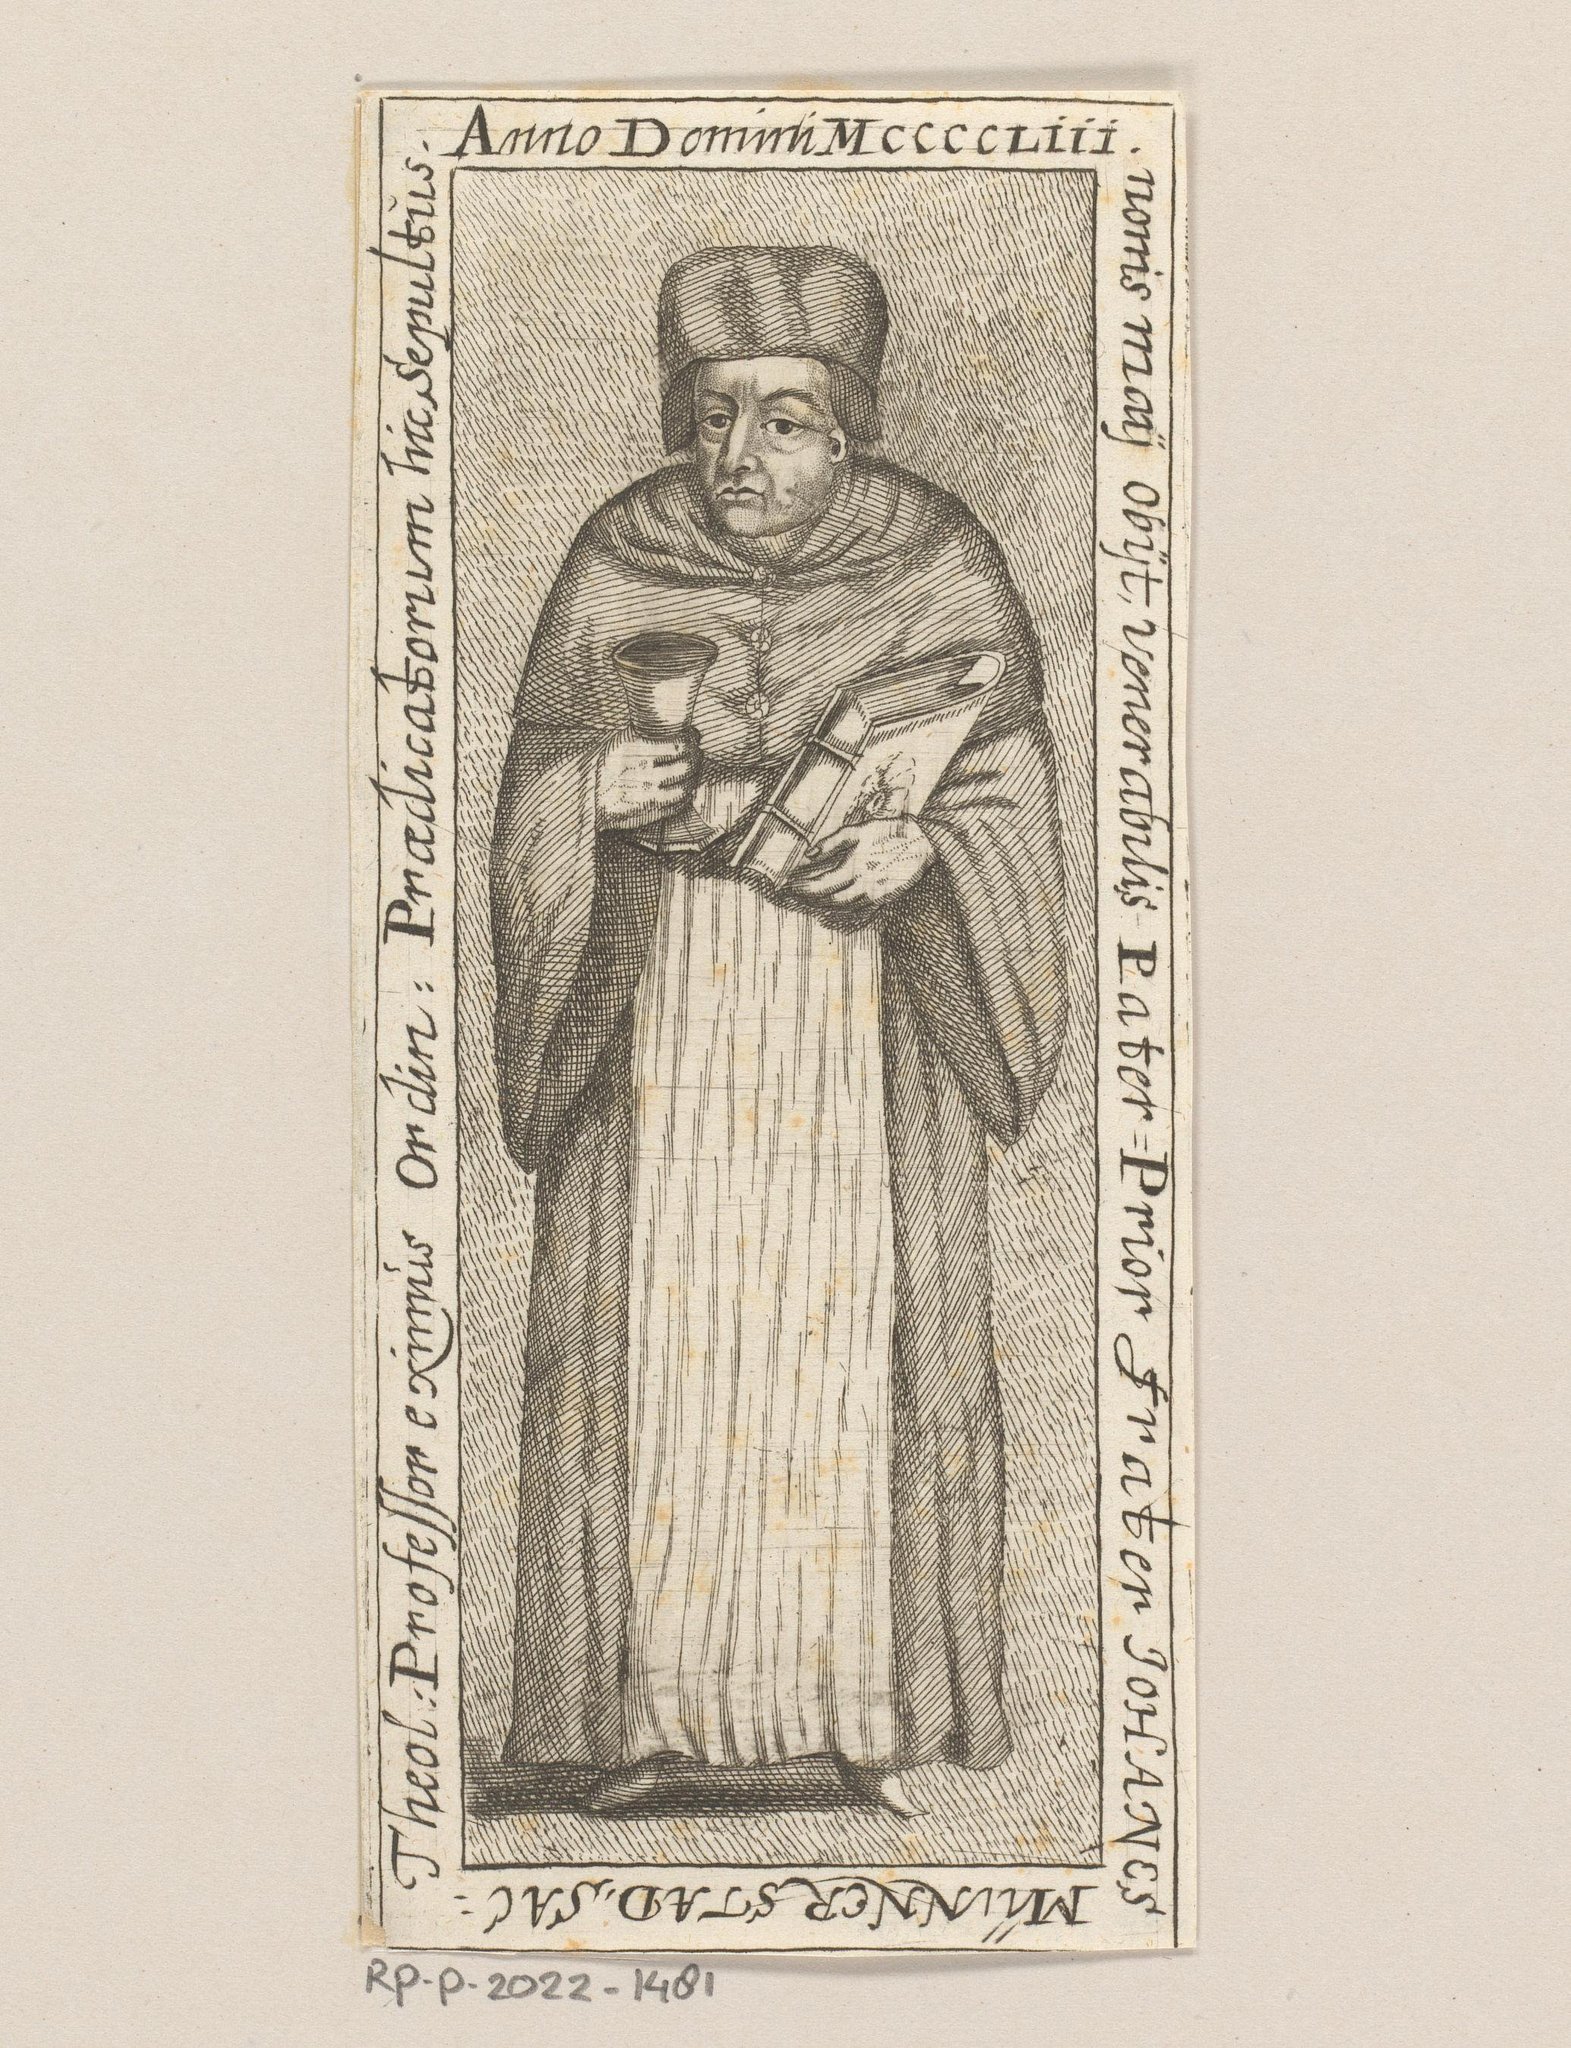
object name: print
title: Portret van Johannes Münnerstadt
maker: Anonymous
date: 1550-1700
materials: paper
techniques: etching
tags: theologian, historical persons